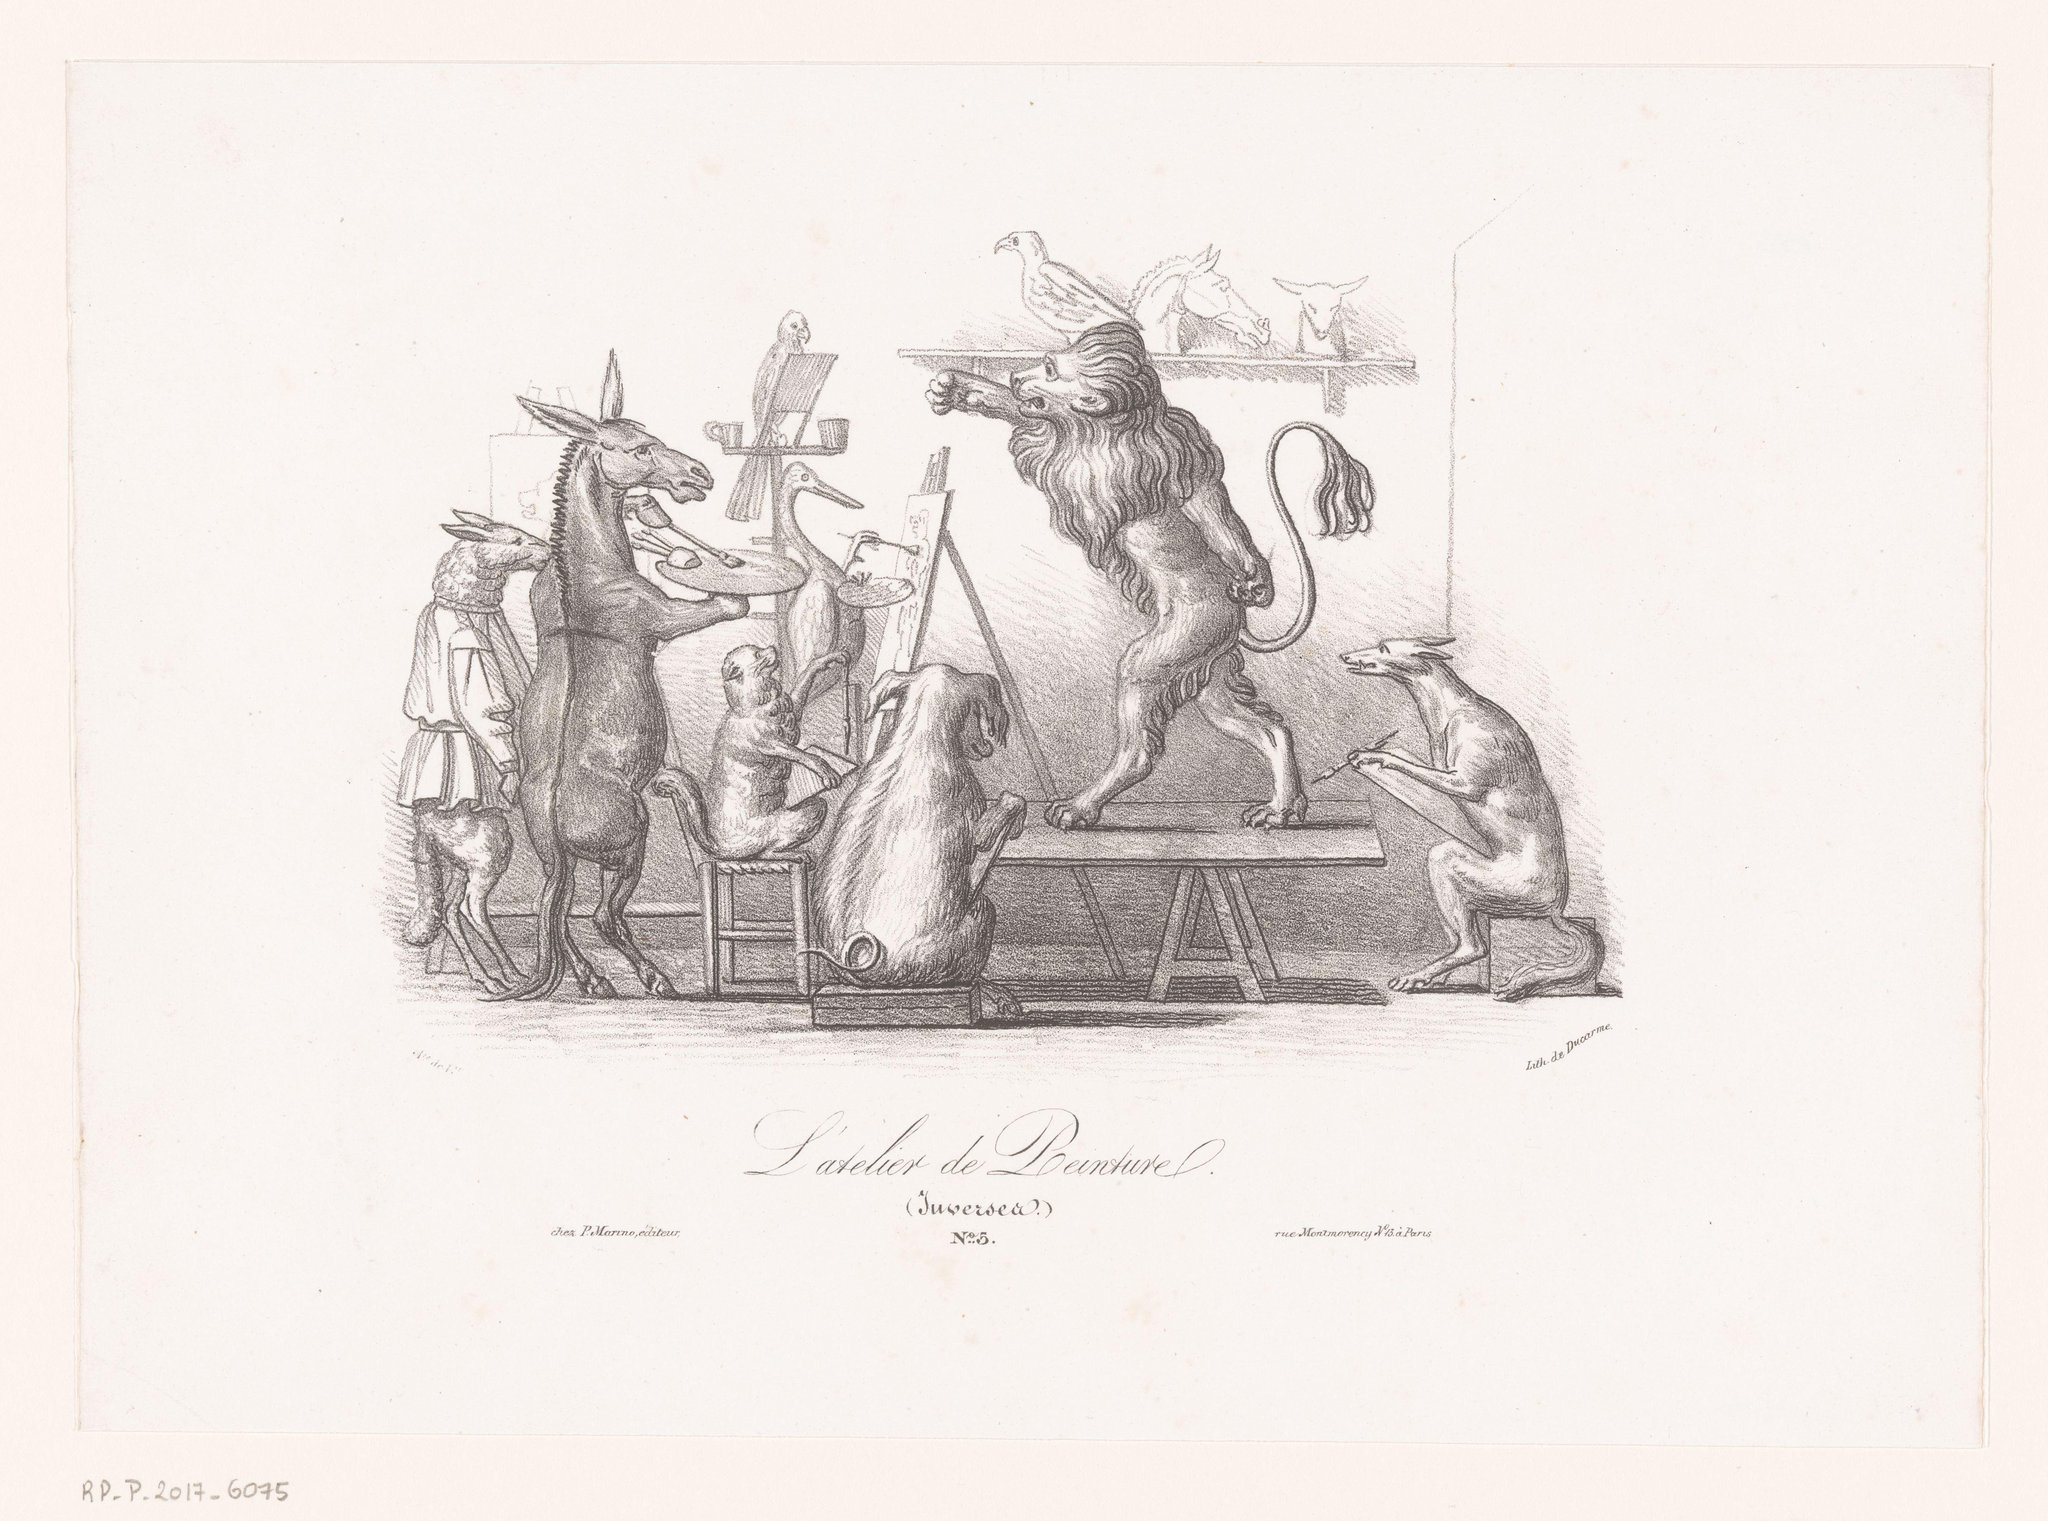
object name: cartoon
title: L'atelier de Peinture (Inversea) No. 5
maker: p. marino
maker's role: publisher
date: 1826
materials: paper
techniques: lithograph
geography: paris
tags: painter working from live model, 'mundus inversus', the reversed world, the topsy-turvy world, 'le monde bestourné', animals (+ animals in caricature), political caricatures and satires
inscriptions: collector's mark: Lugt 2228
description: Atelier met verschillende dieren die een leeuw naschilderen. Onderdeel van een serie van zeven karikaturen met dieren.